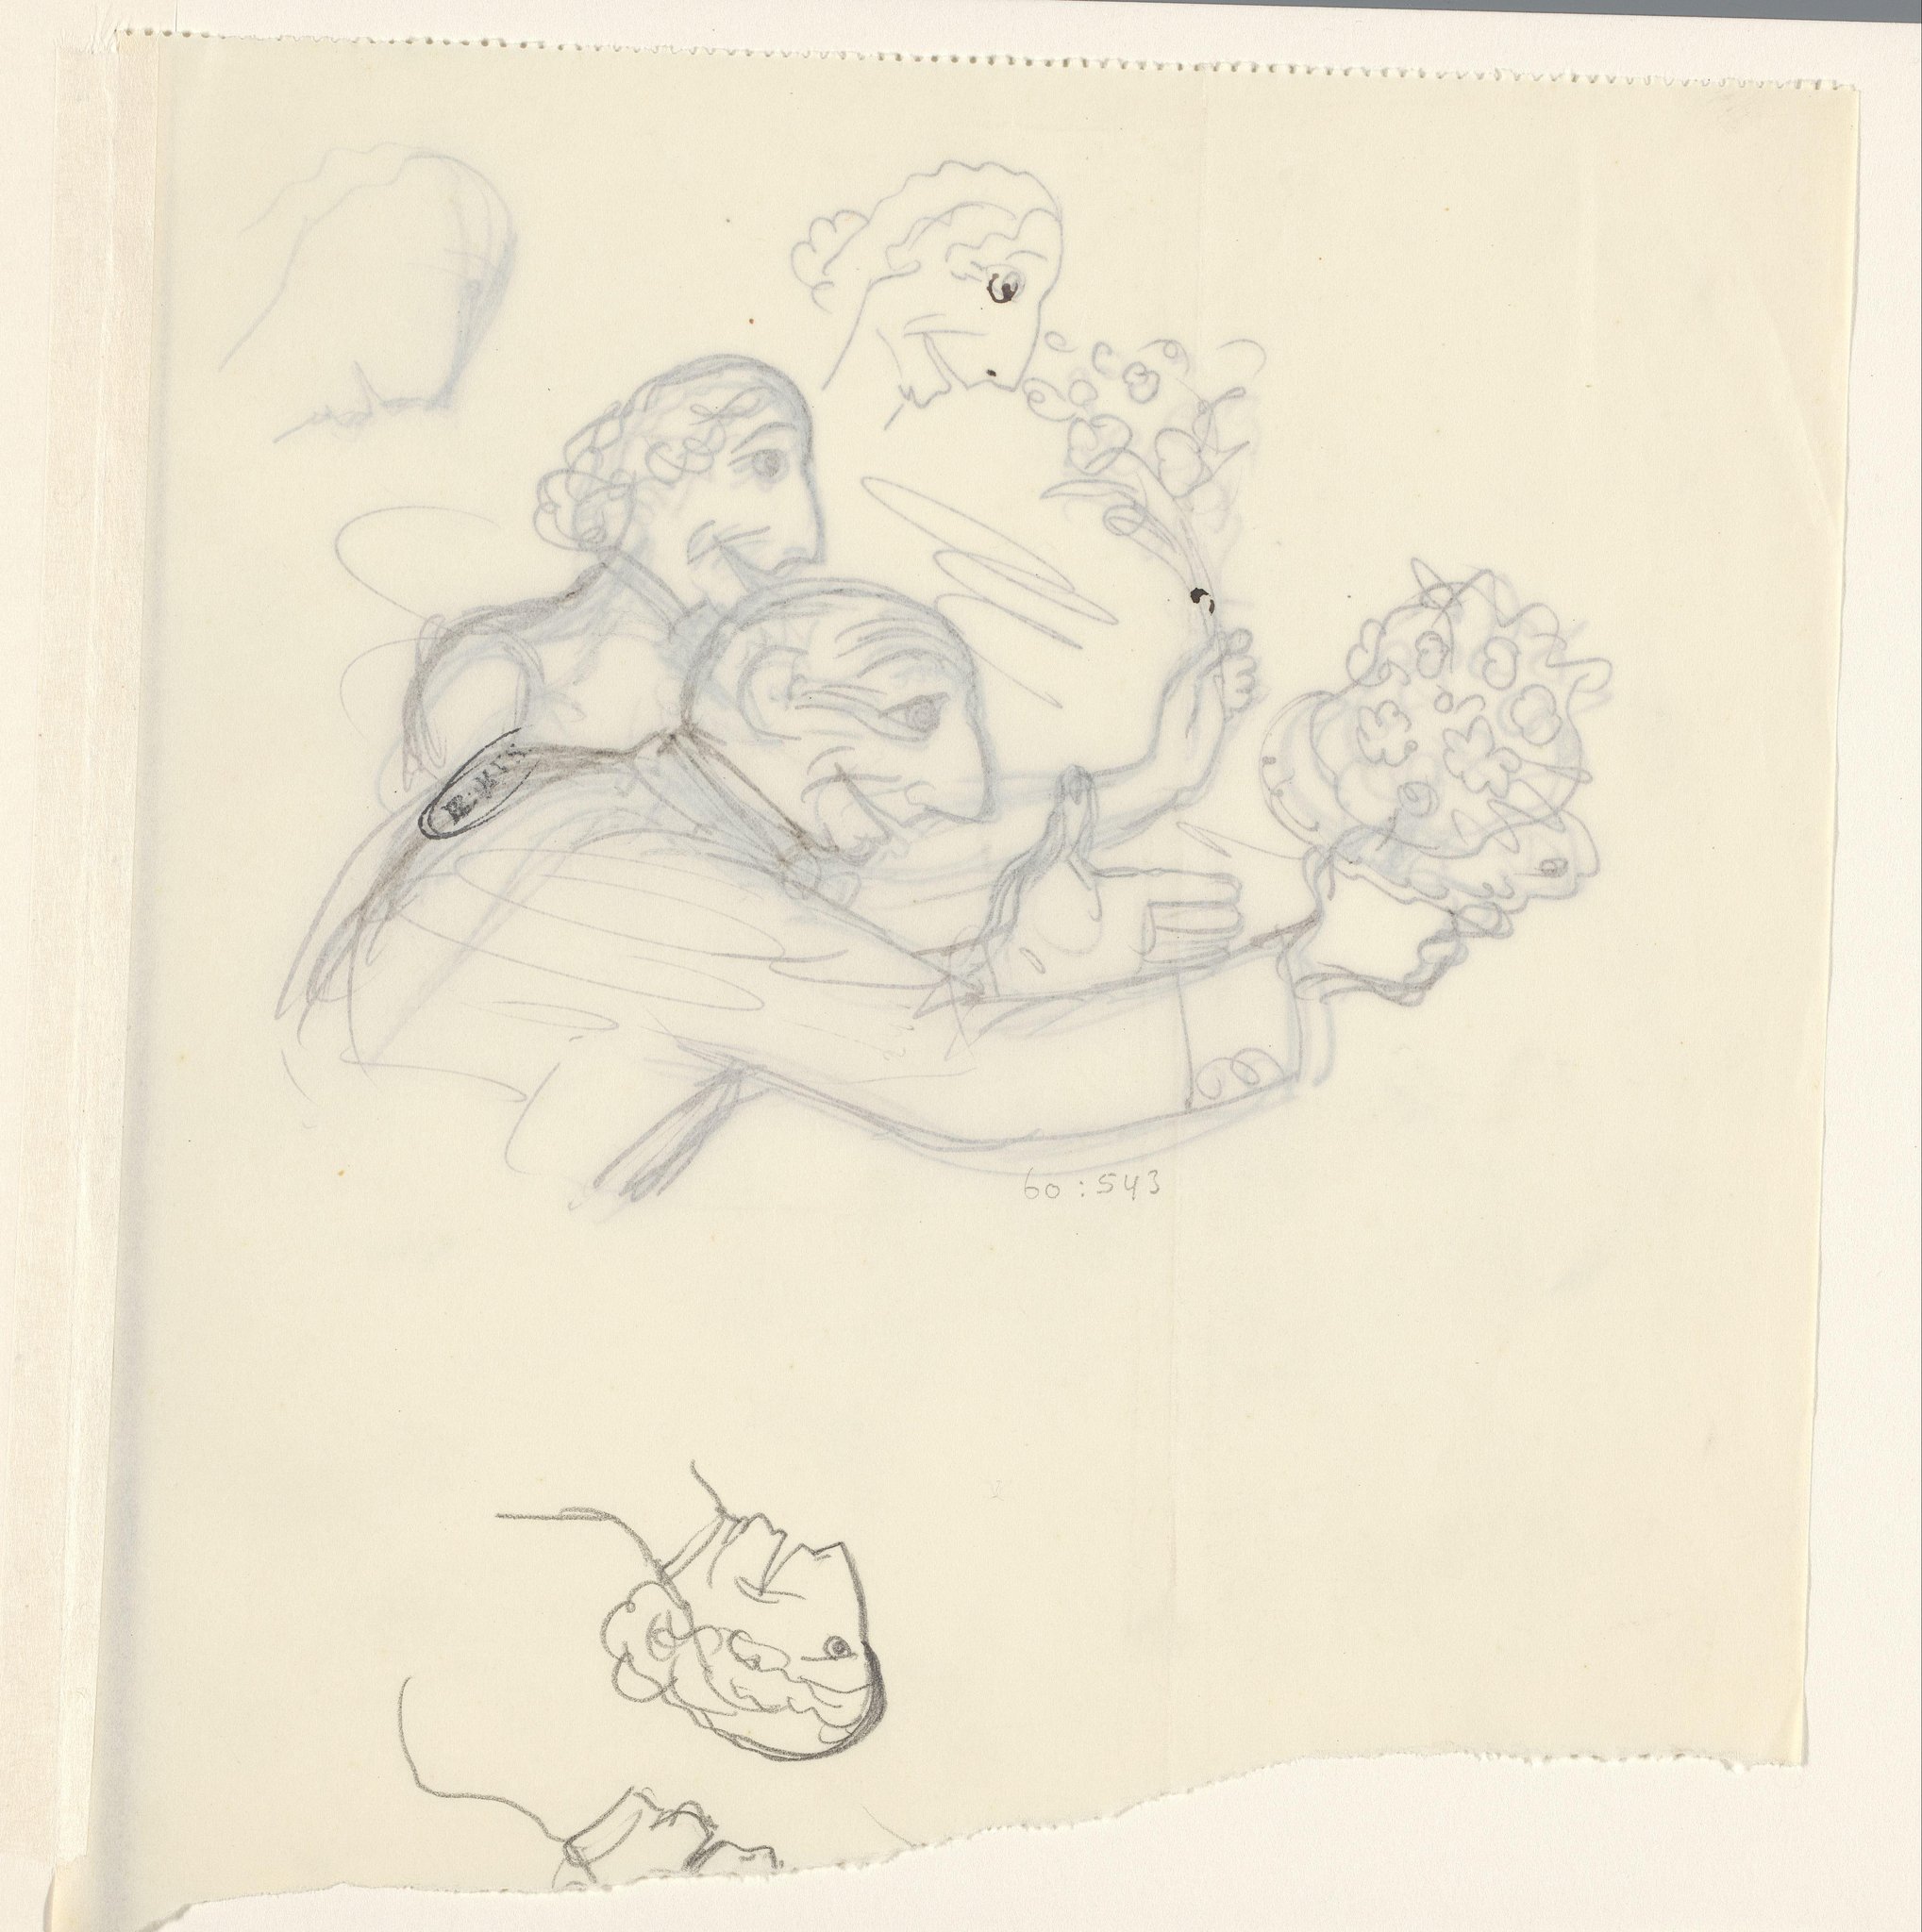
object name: drawing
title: Hoofd van een vrouw, mogelijk An Overtoom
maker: leo gestel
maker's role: draughtsman, print maker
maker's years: 1881-1941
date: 1891-1941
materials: paper, pencil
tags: painter, gerritje gestel-overtoom, historical persons - bb - woman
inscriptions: collector's mark: Lugt 2228